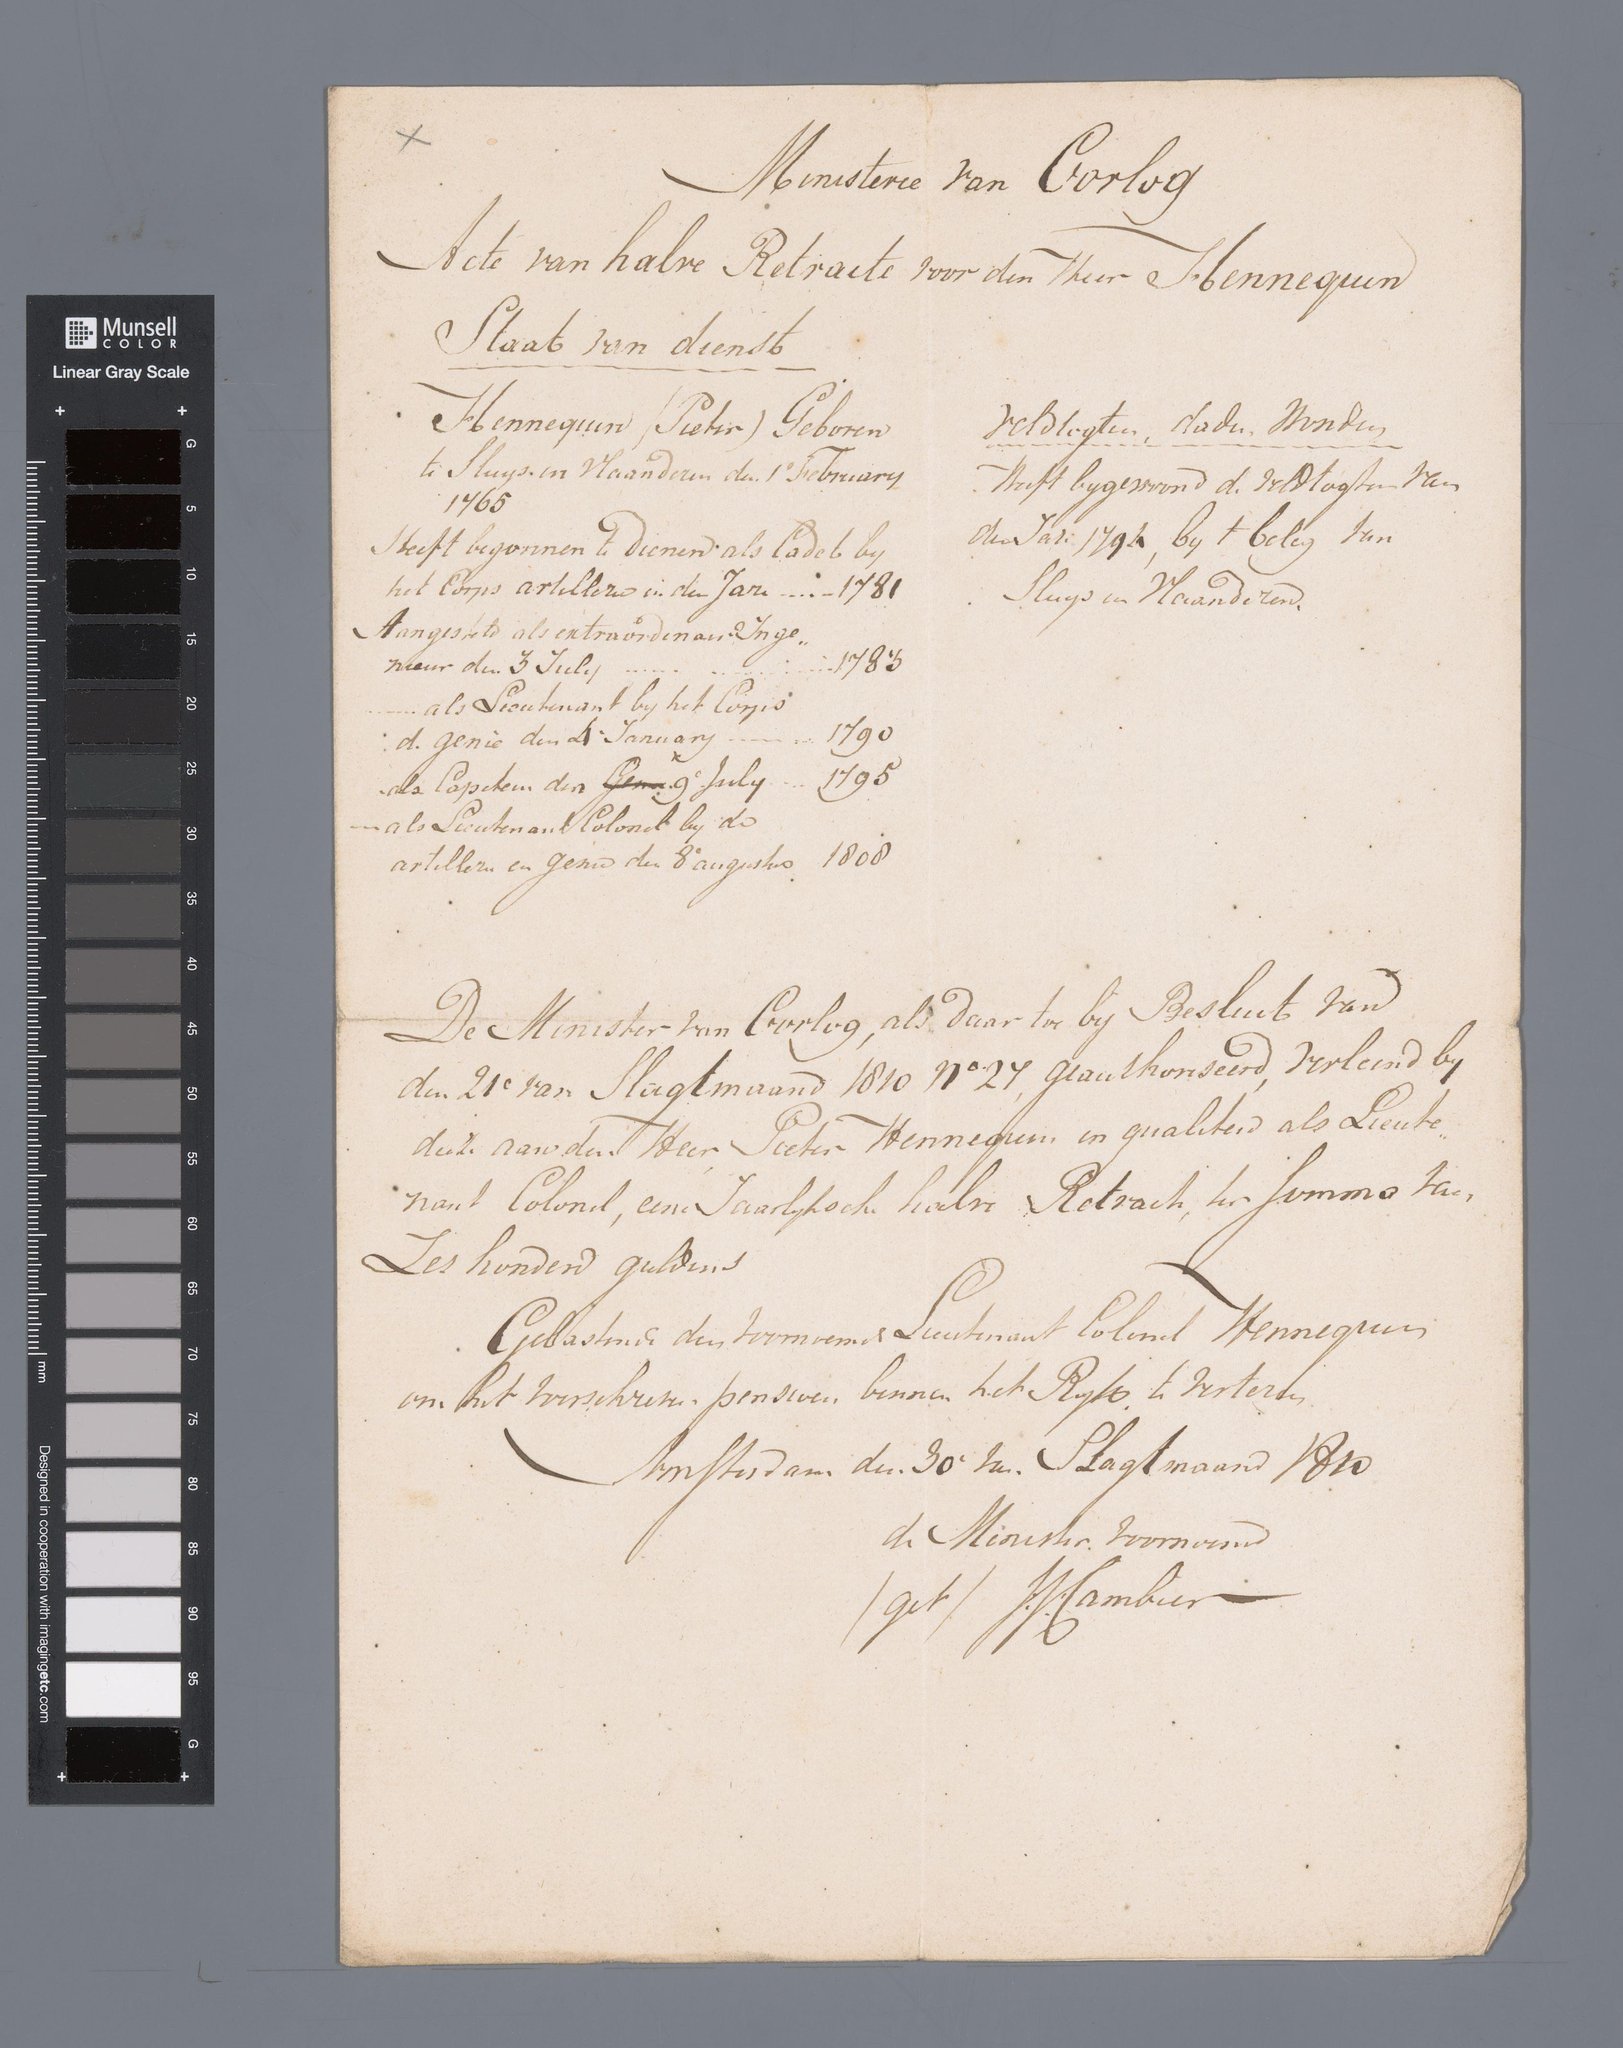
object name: document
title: Acte van halve Retraite voor den Heer Hennequin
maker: j. j. cambier (minister van oorlog)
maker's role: eerste kamerlid, ambassadeur, minister, representant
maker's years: 1756-1831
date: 1810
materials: ink, paper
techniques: writing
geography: amsterdam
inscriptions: date